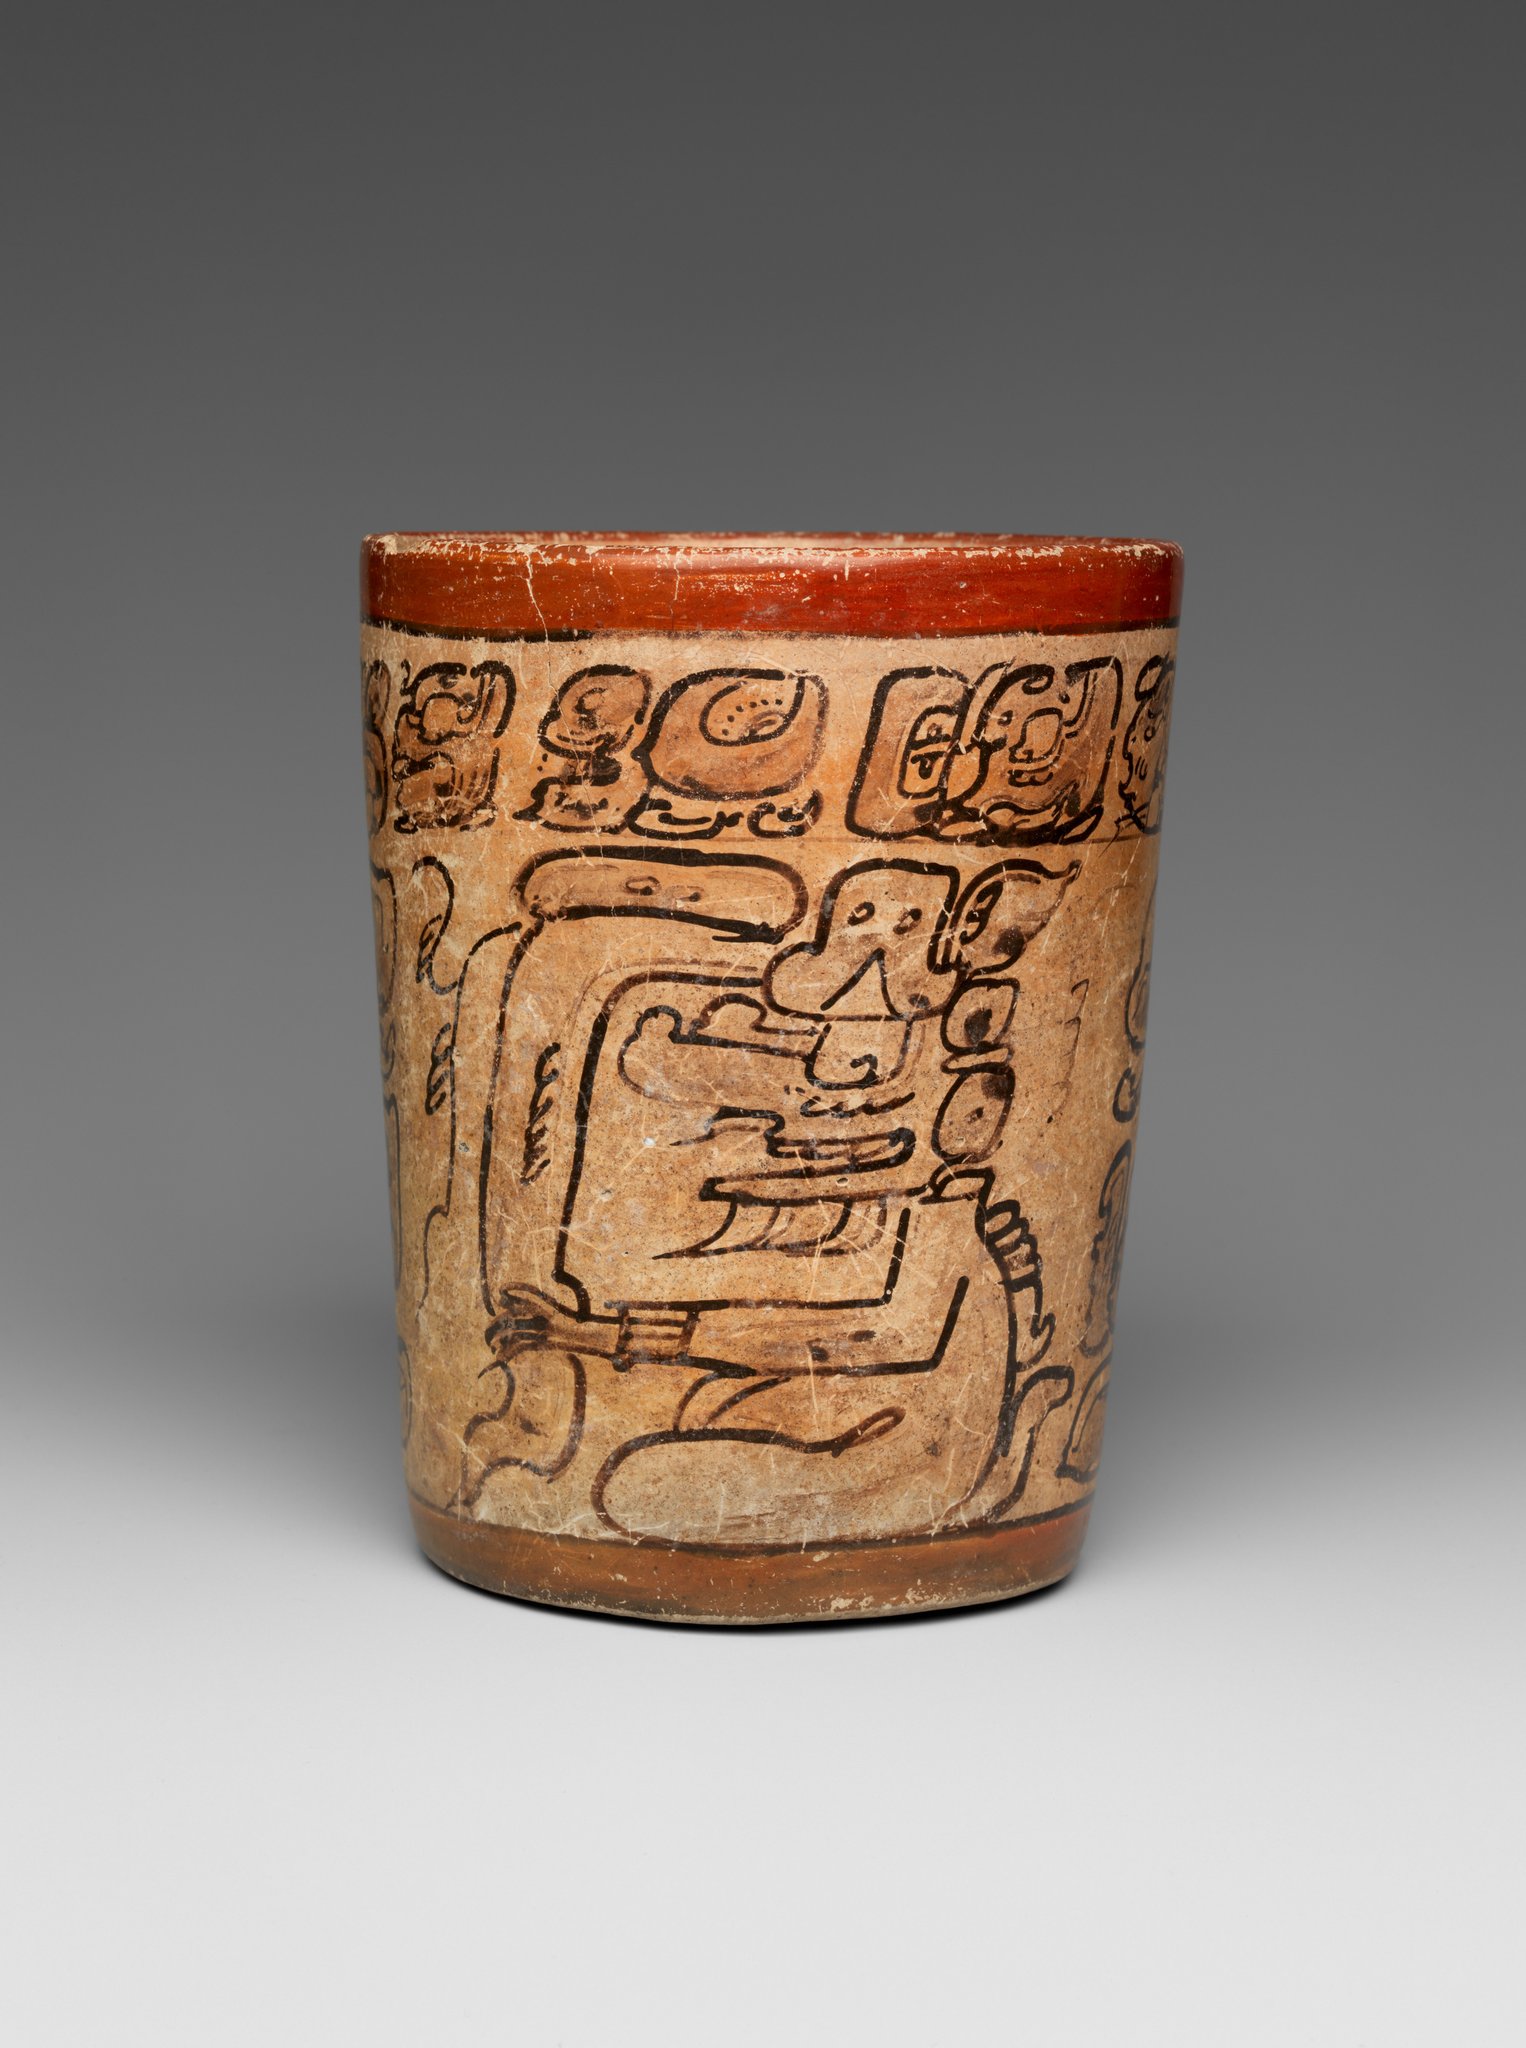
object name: vessel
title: Cylindrical Vessel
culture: maya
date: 601-800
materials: ceramic, pigment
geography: guatemala or mexico